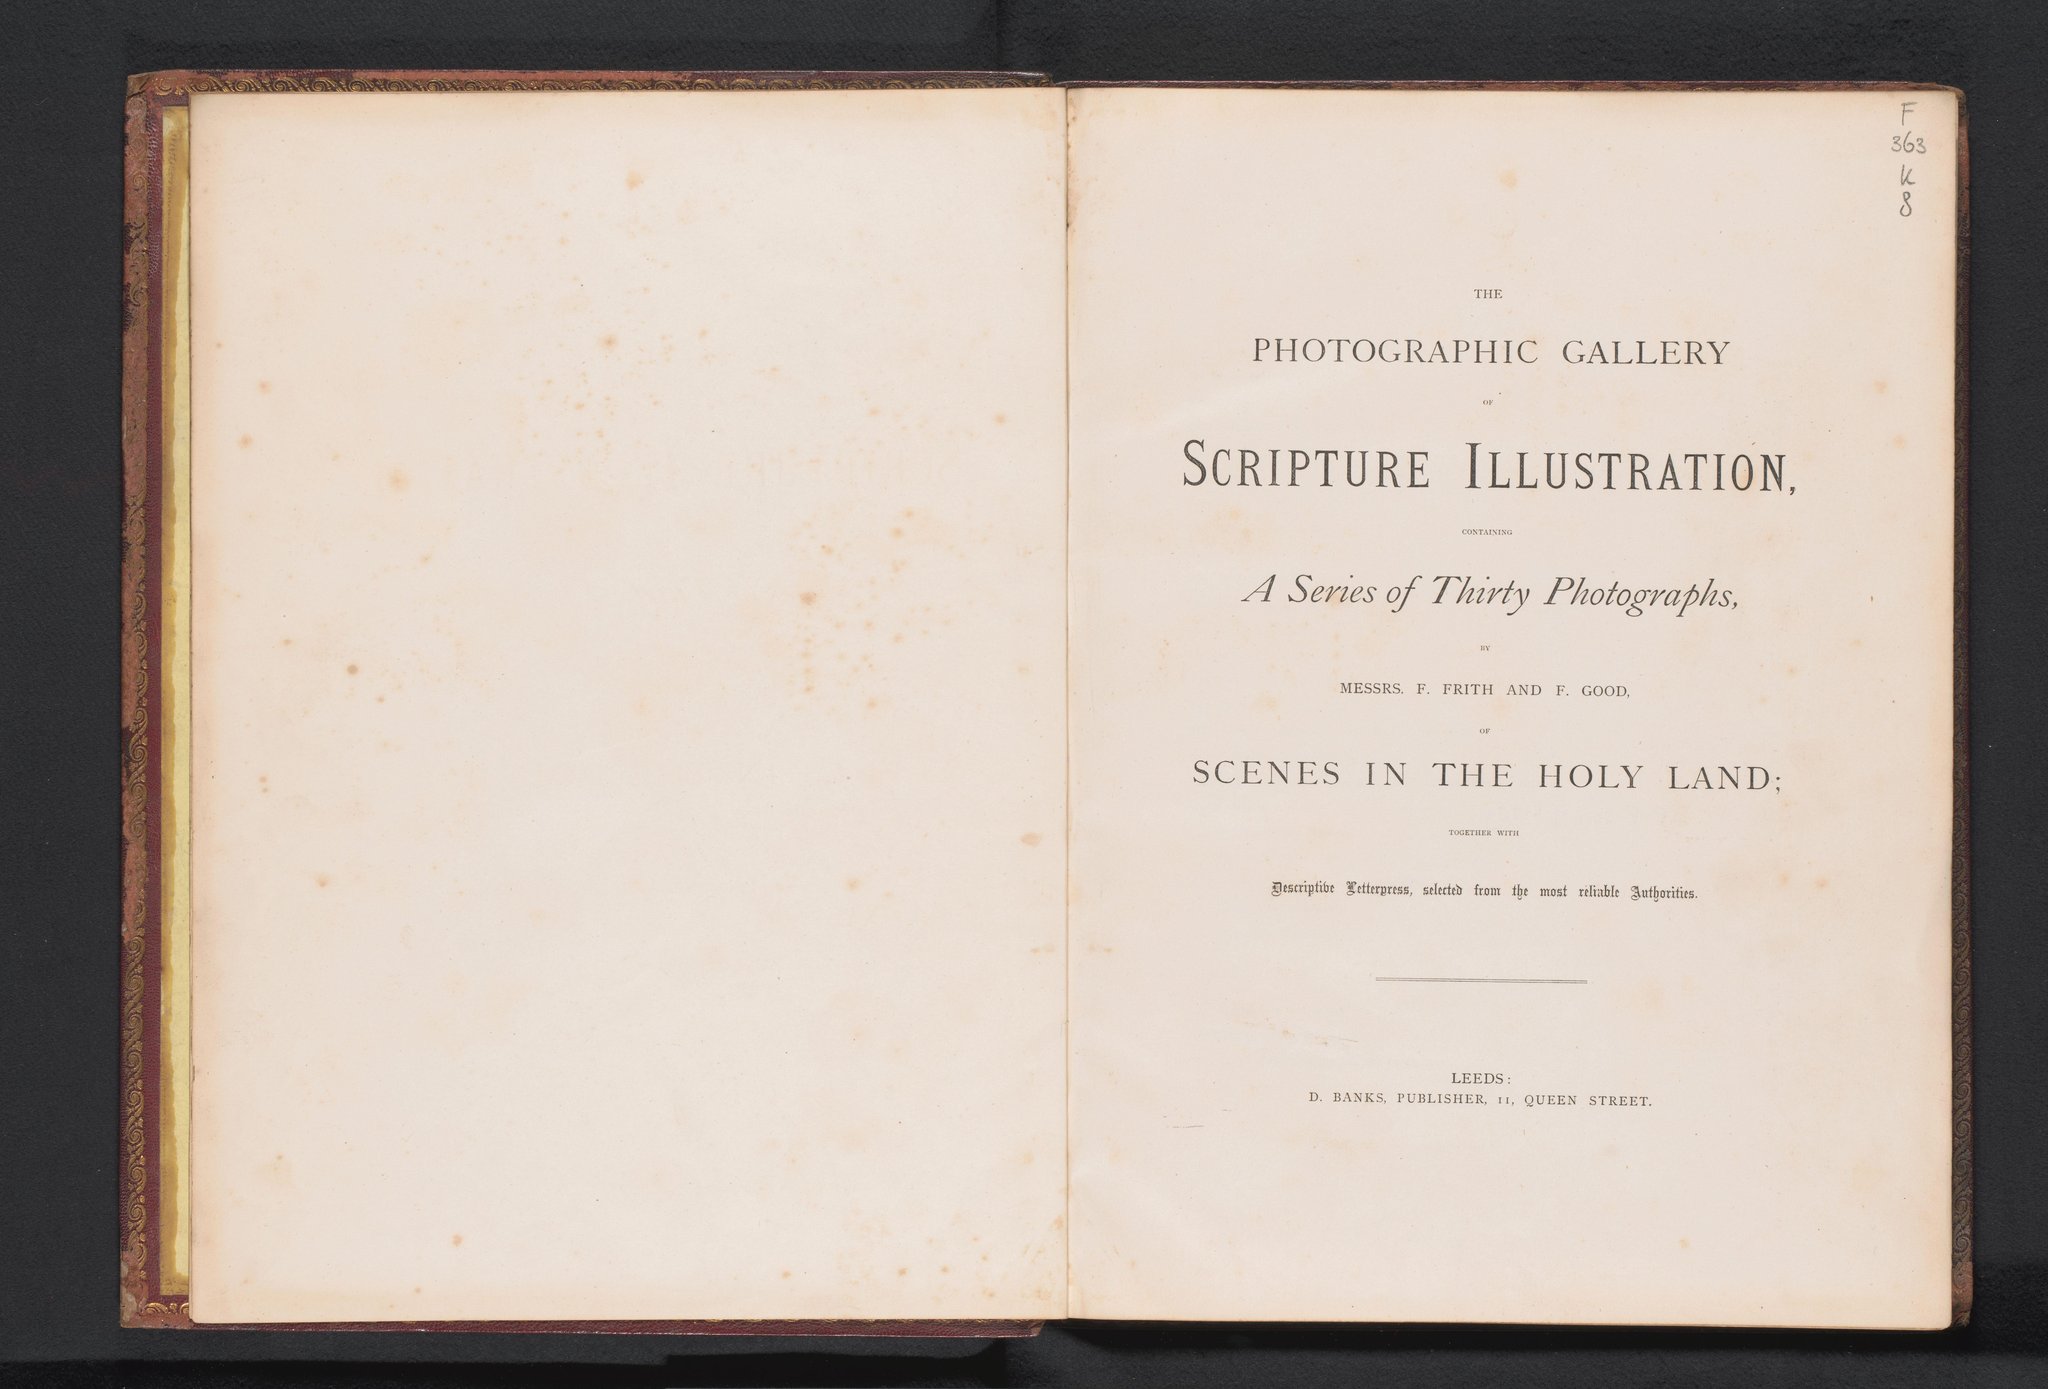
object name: book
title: The photographic gallery of scripture illustration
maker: d. banks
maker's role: publisher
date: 1875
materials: cardboard, leather, linen, paper, photographic support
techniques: albumen print, printing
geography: leeds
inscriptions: date: ‘OCT 1991’